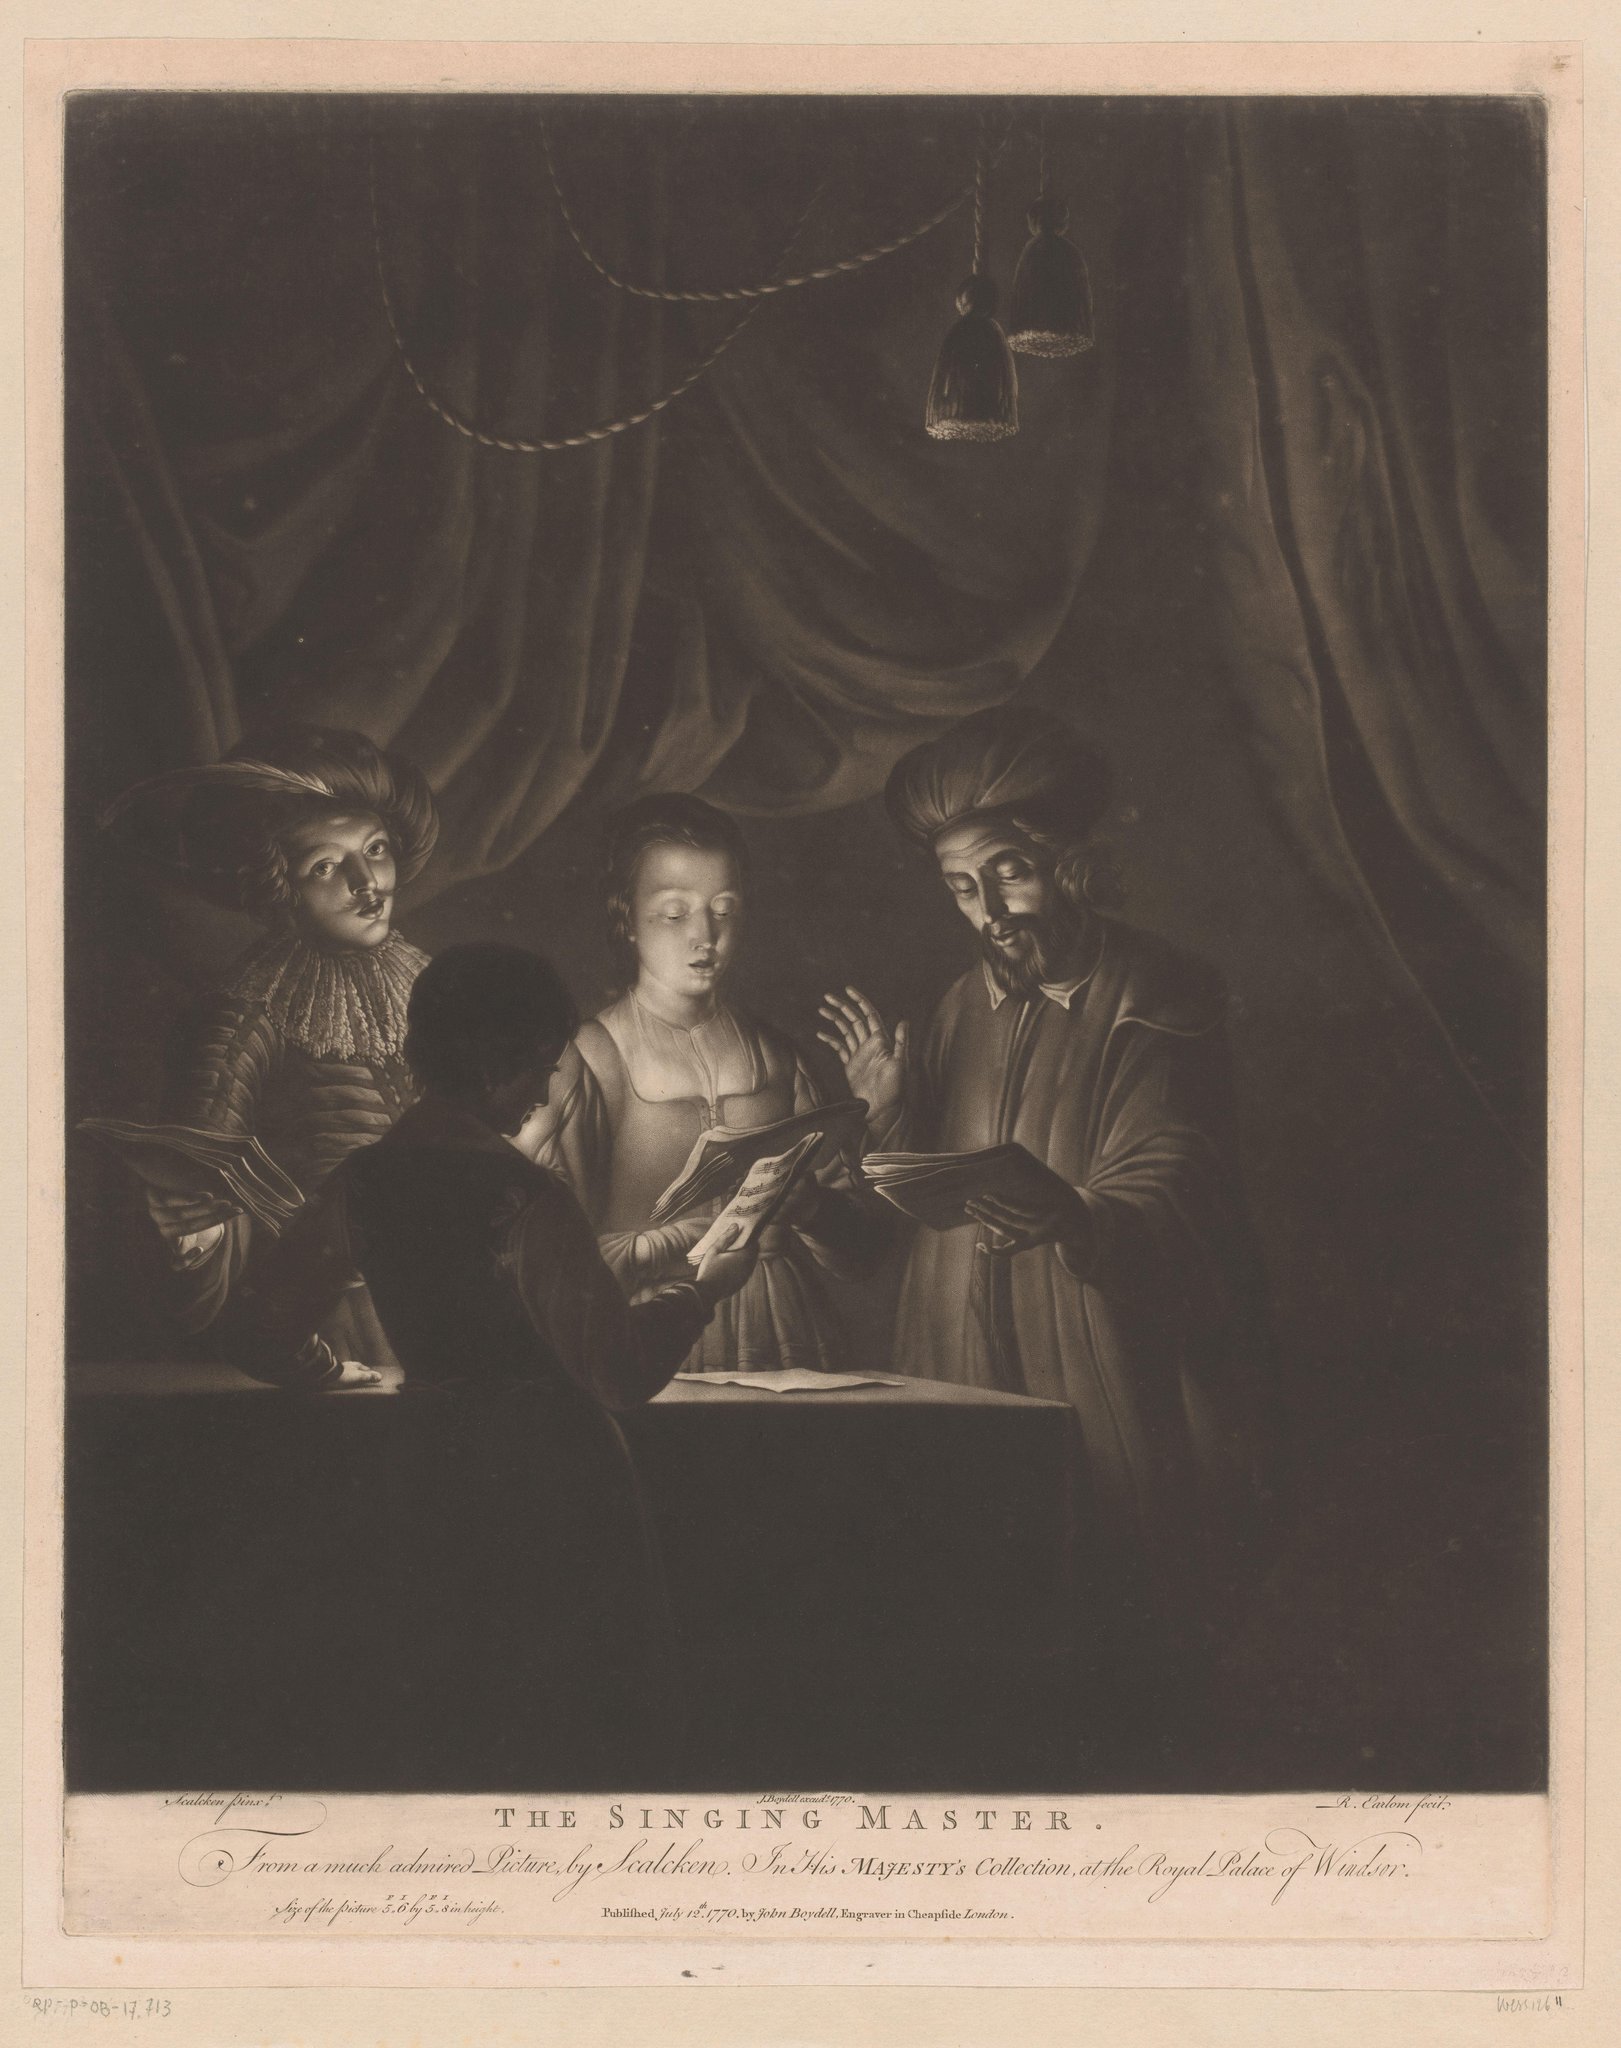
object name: print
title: Das Quartet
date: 1770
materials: paper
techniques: etching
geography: london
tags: small group of musicians, chamber orchestra, jazz band, teacher and pupil, vocal music, singing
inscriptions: collector's mark: Lugt 240